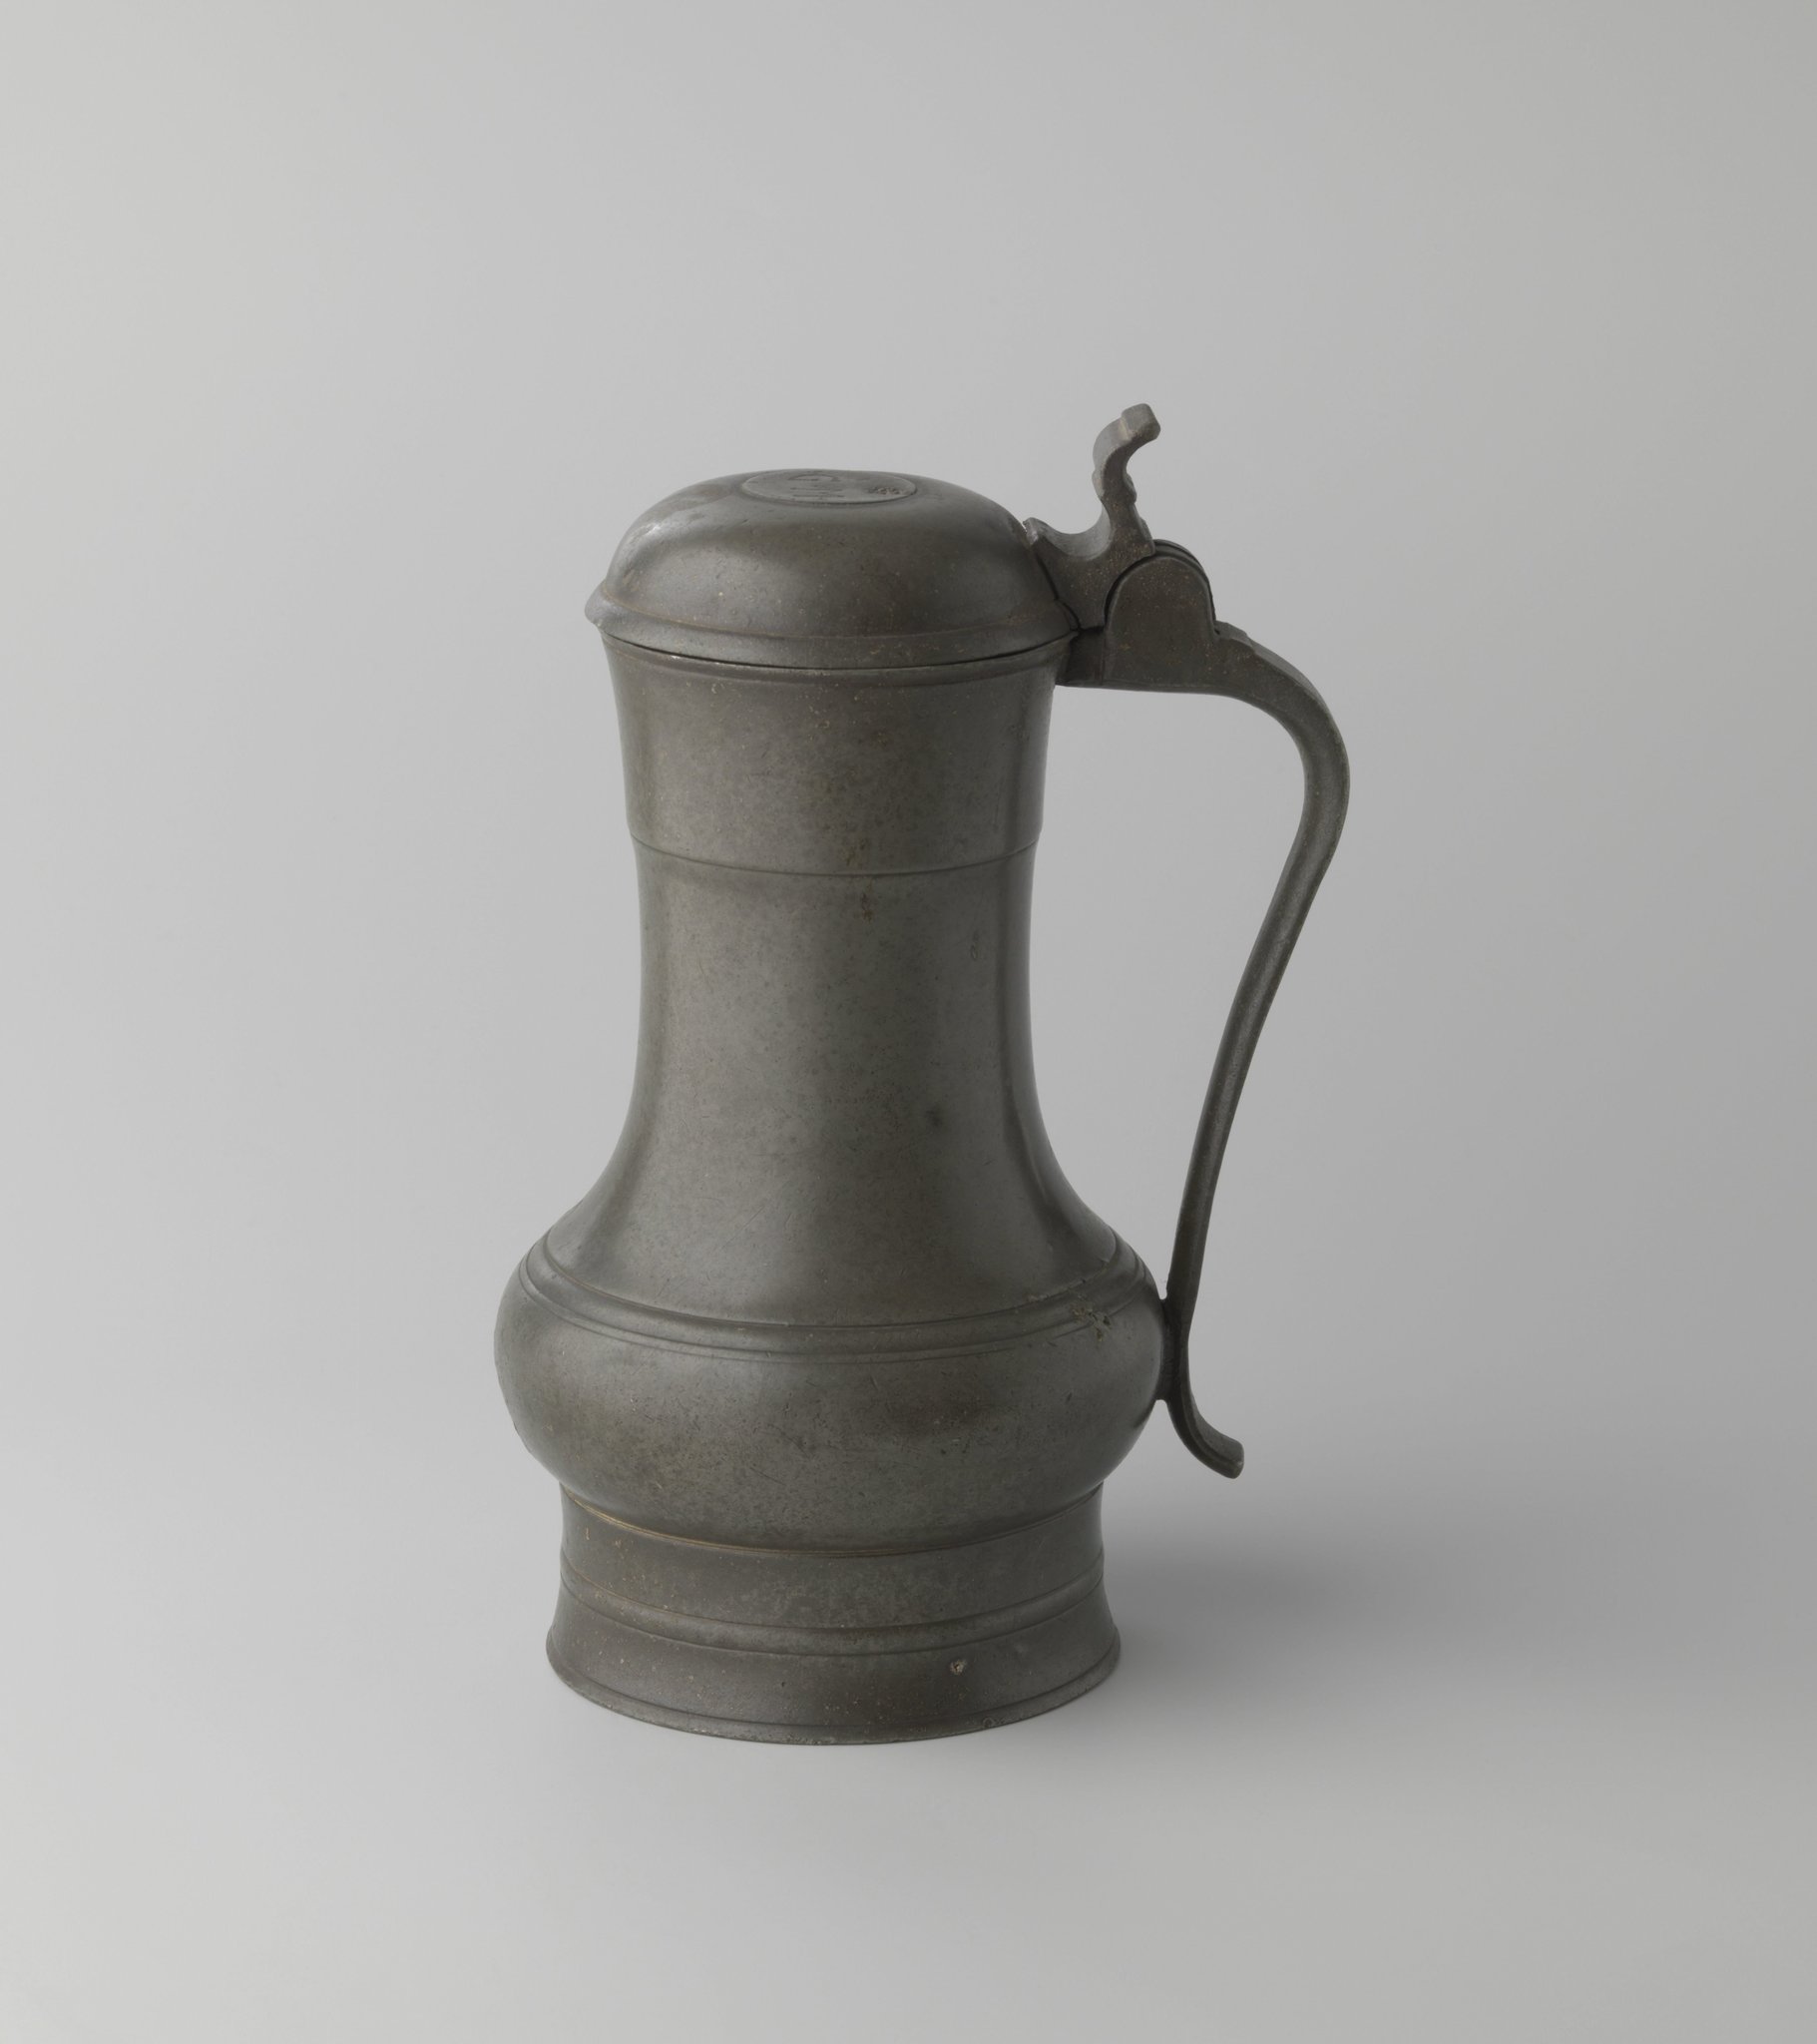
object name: jug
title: Kruik van tin (Rembrandtkan)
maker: Anonymous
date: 1675-1725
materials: tin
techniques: casting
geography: northern netherlands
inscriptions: quality mark, inscription: ‘GM’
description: Kan van tin, een zg. Rembrandt-kan. Op de hoge standring rust de lage buik die in de nauwe hals met bandvormige liprand overgaat. De kan heeft een dubbelkakig scharnier, een gewelfde deksel en is van profileringen voorzien. Op het deksel later aangebracht de initialen G.M., en zegel aan de binnenrand. De buik vertoont twee door tinpest aangetaste plaatsen.